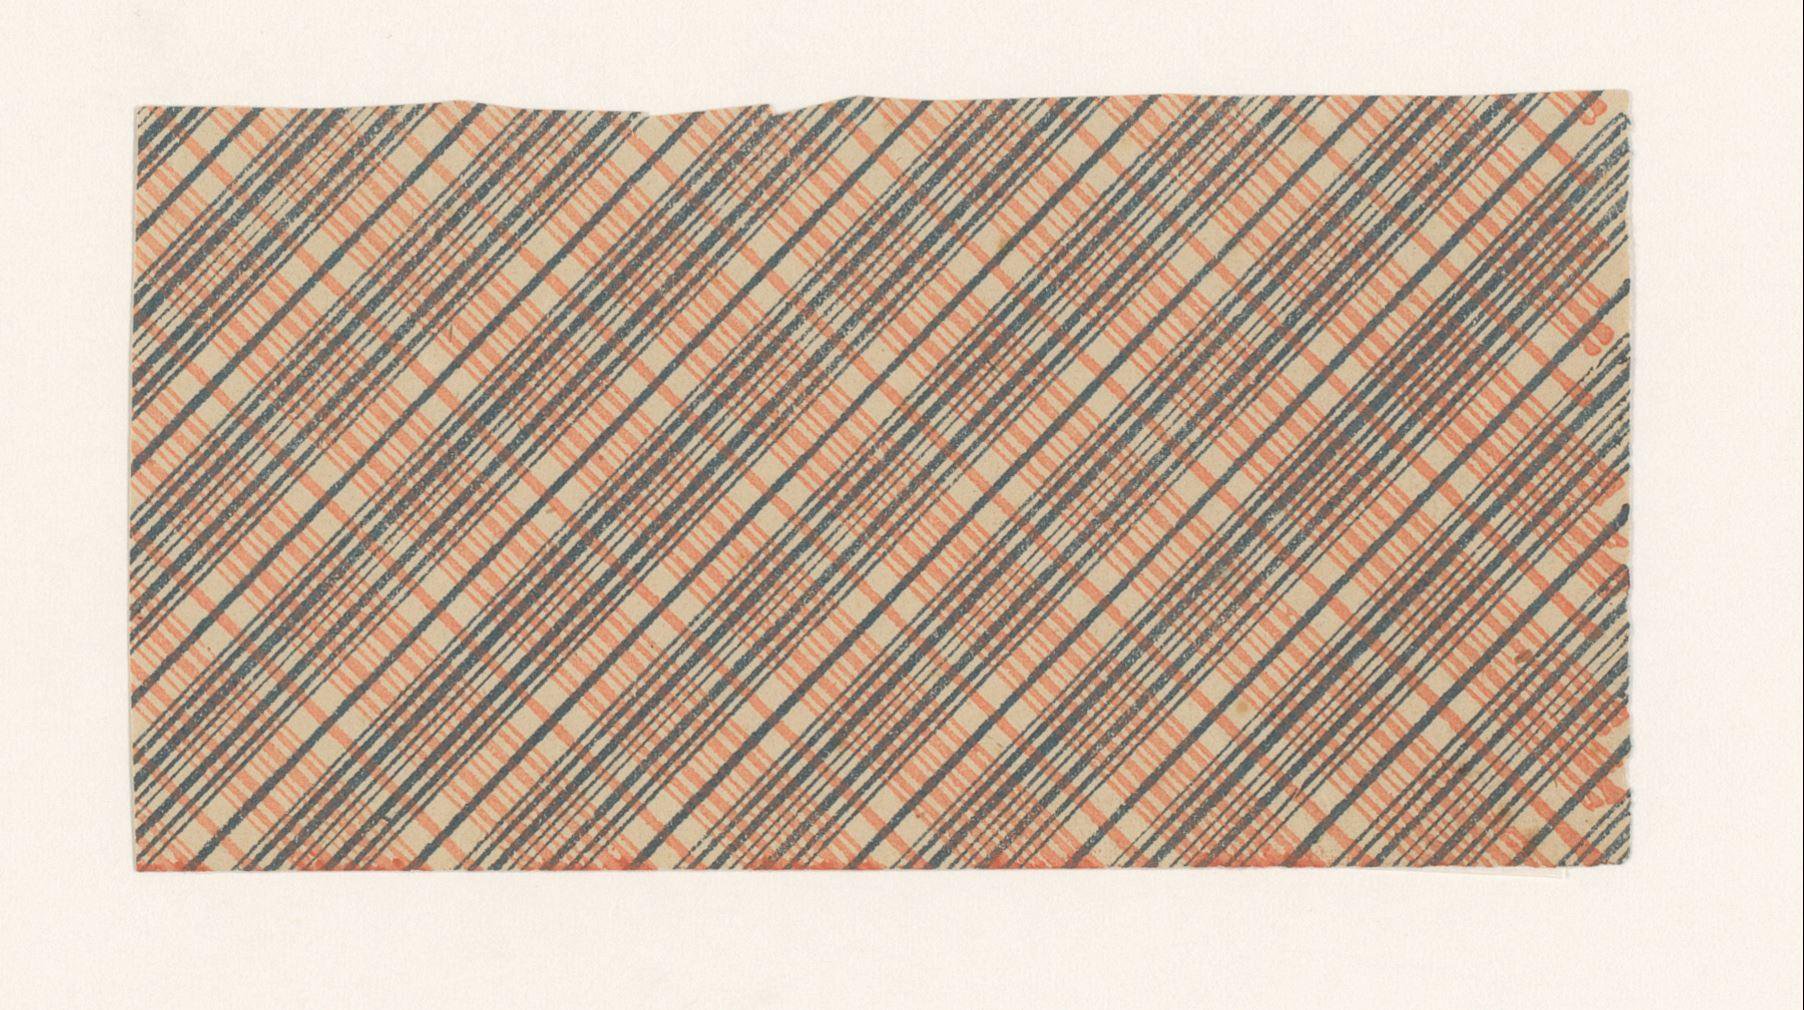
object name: printed paper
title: Blad met patroon met strepen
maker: Anonymous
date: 1750-1900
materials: paper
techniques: printing block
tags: ornament ~ geometric motifs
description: Blad met ruitenpatroon van diagonale strepen.